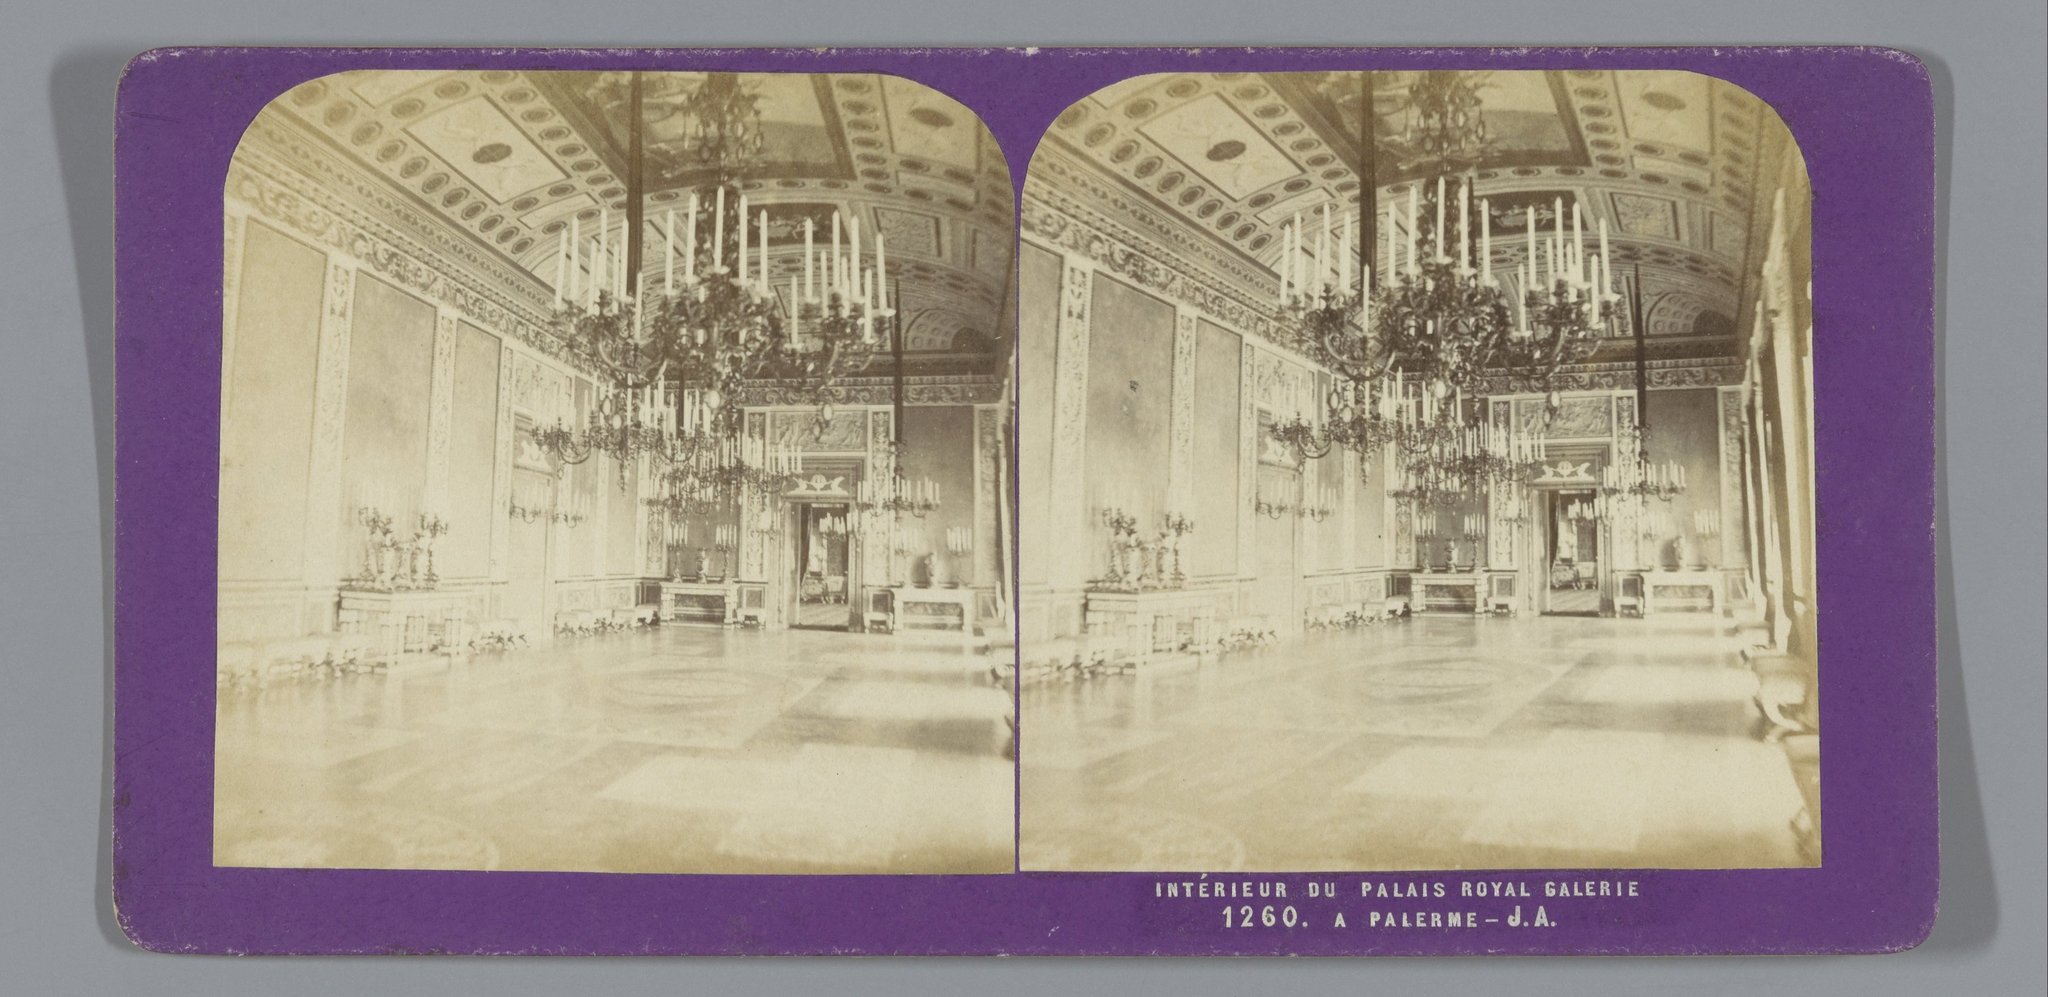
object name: stereograph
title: Intérieur du Palais Royal Galerie a Palerme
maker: jean andrieu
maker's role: fotograaf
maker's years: 1816-1872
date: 1862-1876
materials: cardboard, paper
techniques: albumen print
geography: palermo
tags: palace, gallery (spacious corridor)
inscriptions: number: ‘1260’